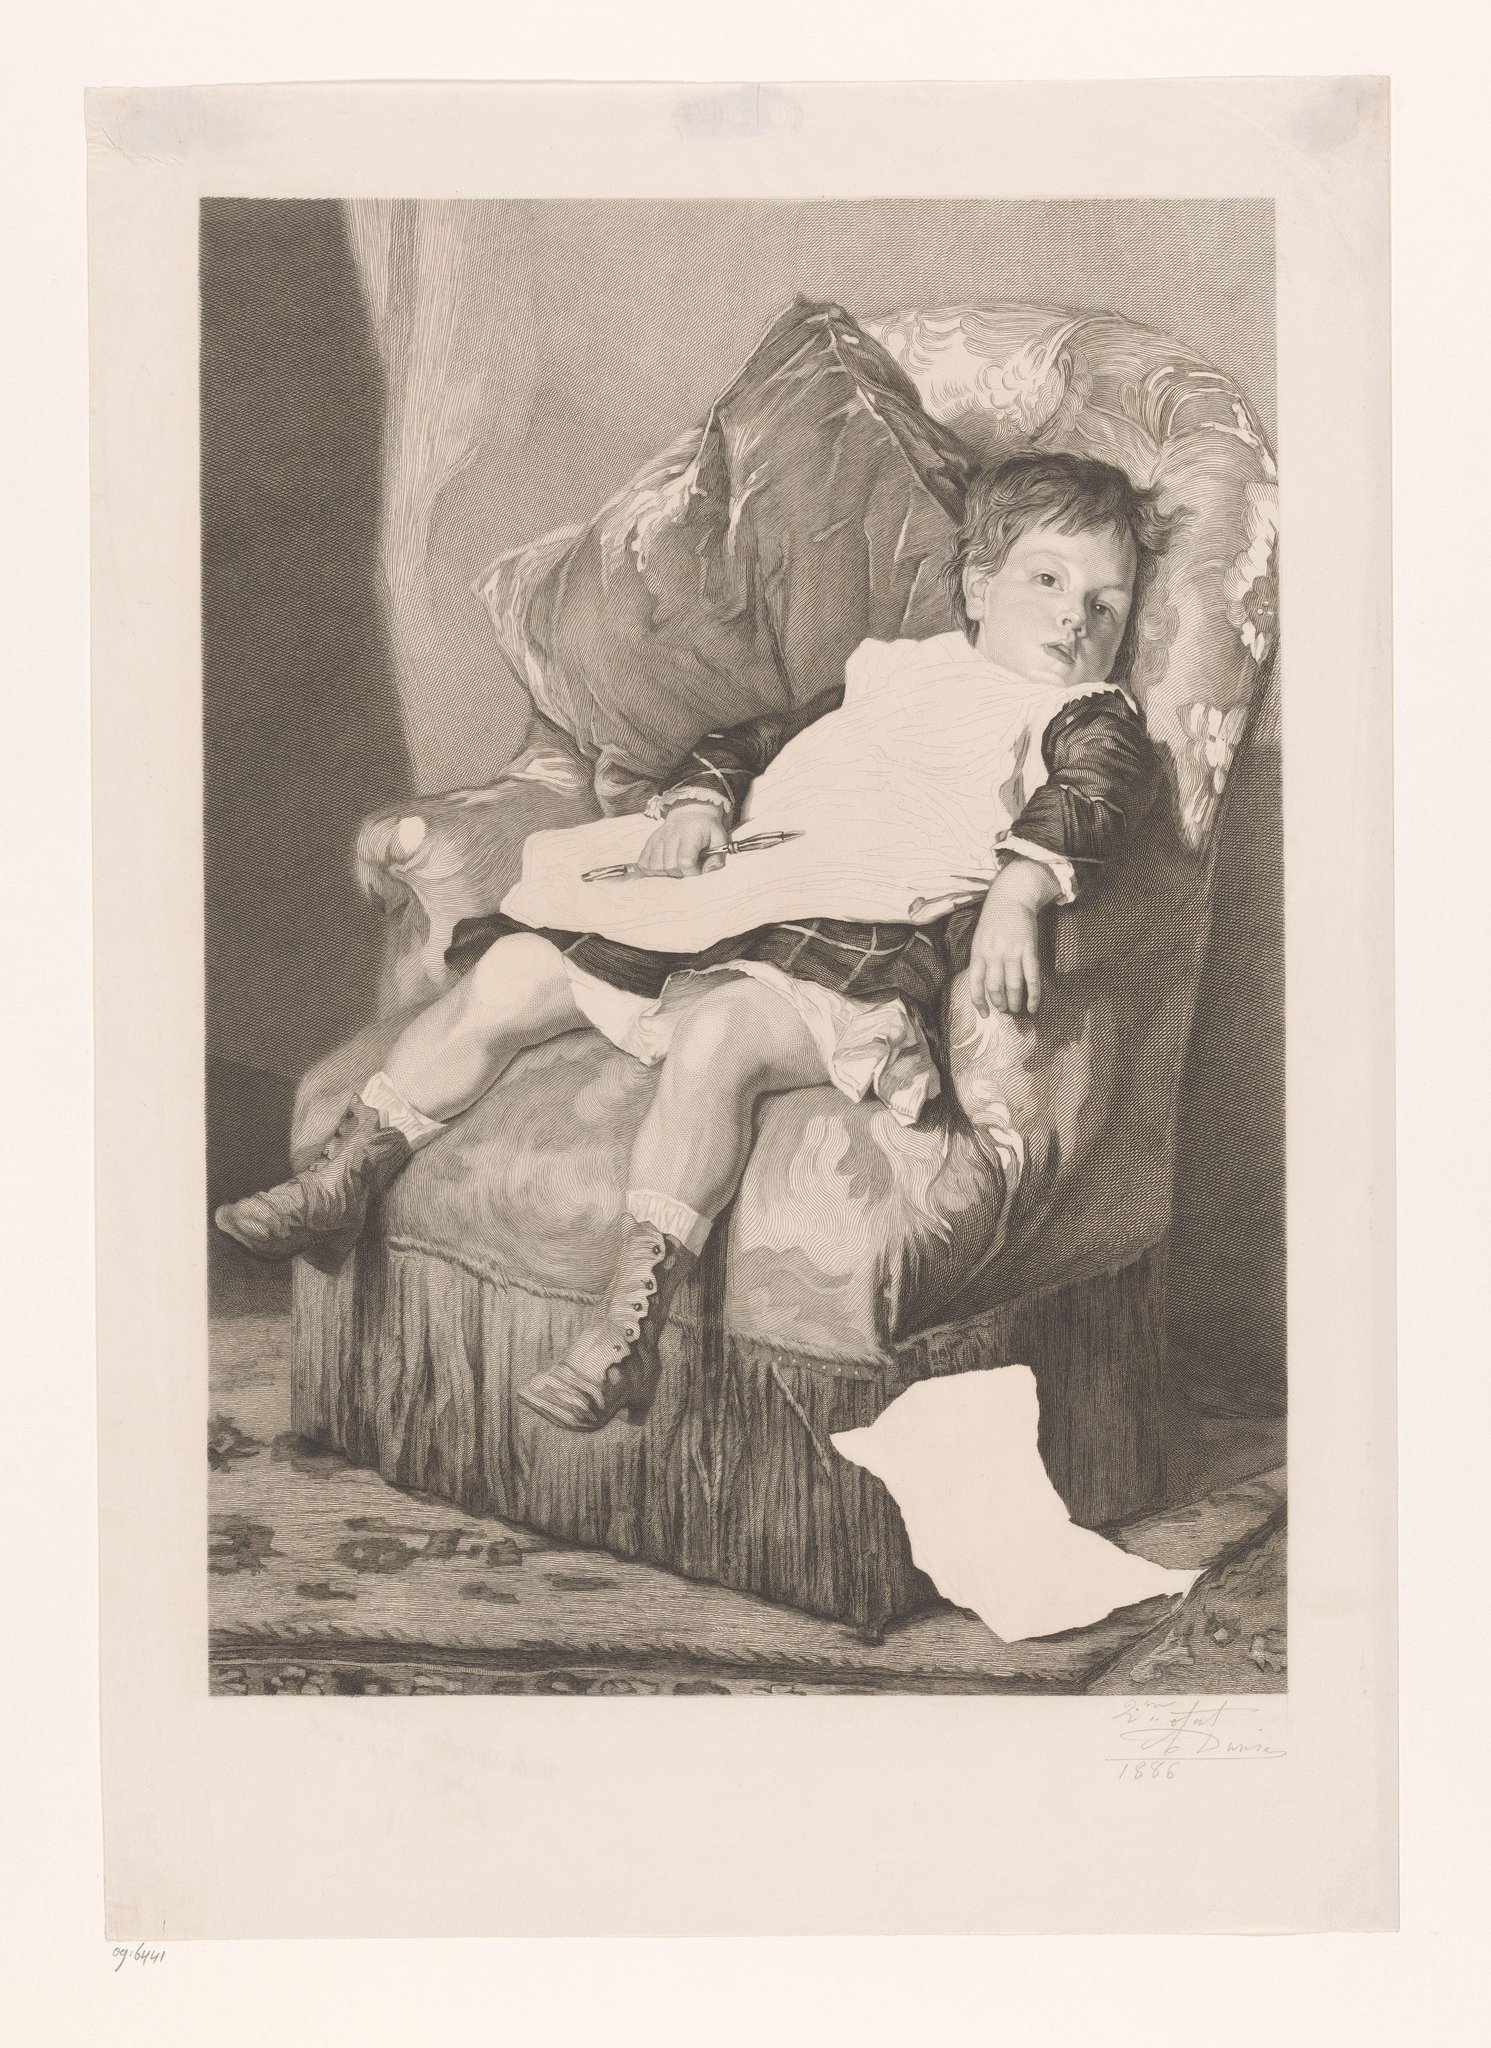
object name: print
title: Jongen op een stoel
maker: auguste danse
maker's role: print maker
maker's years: 1829-1929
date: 1886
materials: paper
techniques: engraving, etching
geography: bergen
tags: boy (child between toddler and youth), child (at home)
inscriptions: collector's mark: Lugt 2228, annotation: ‘2me état’